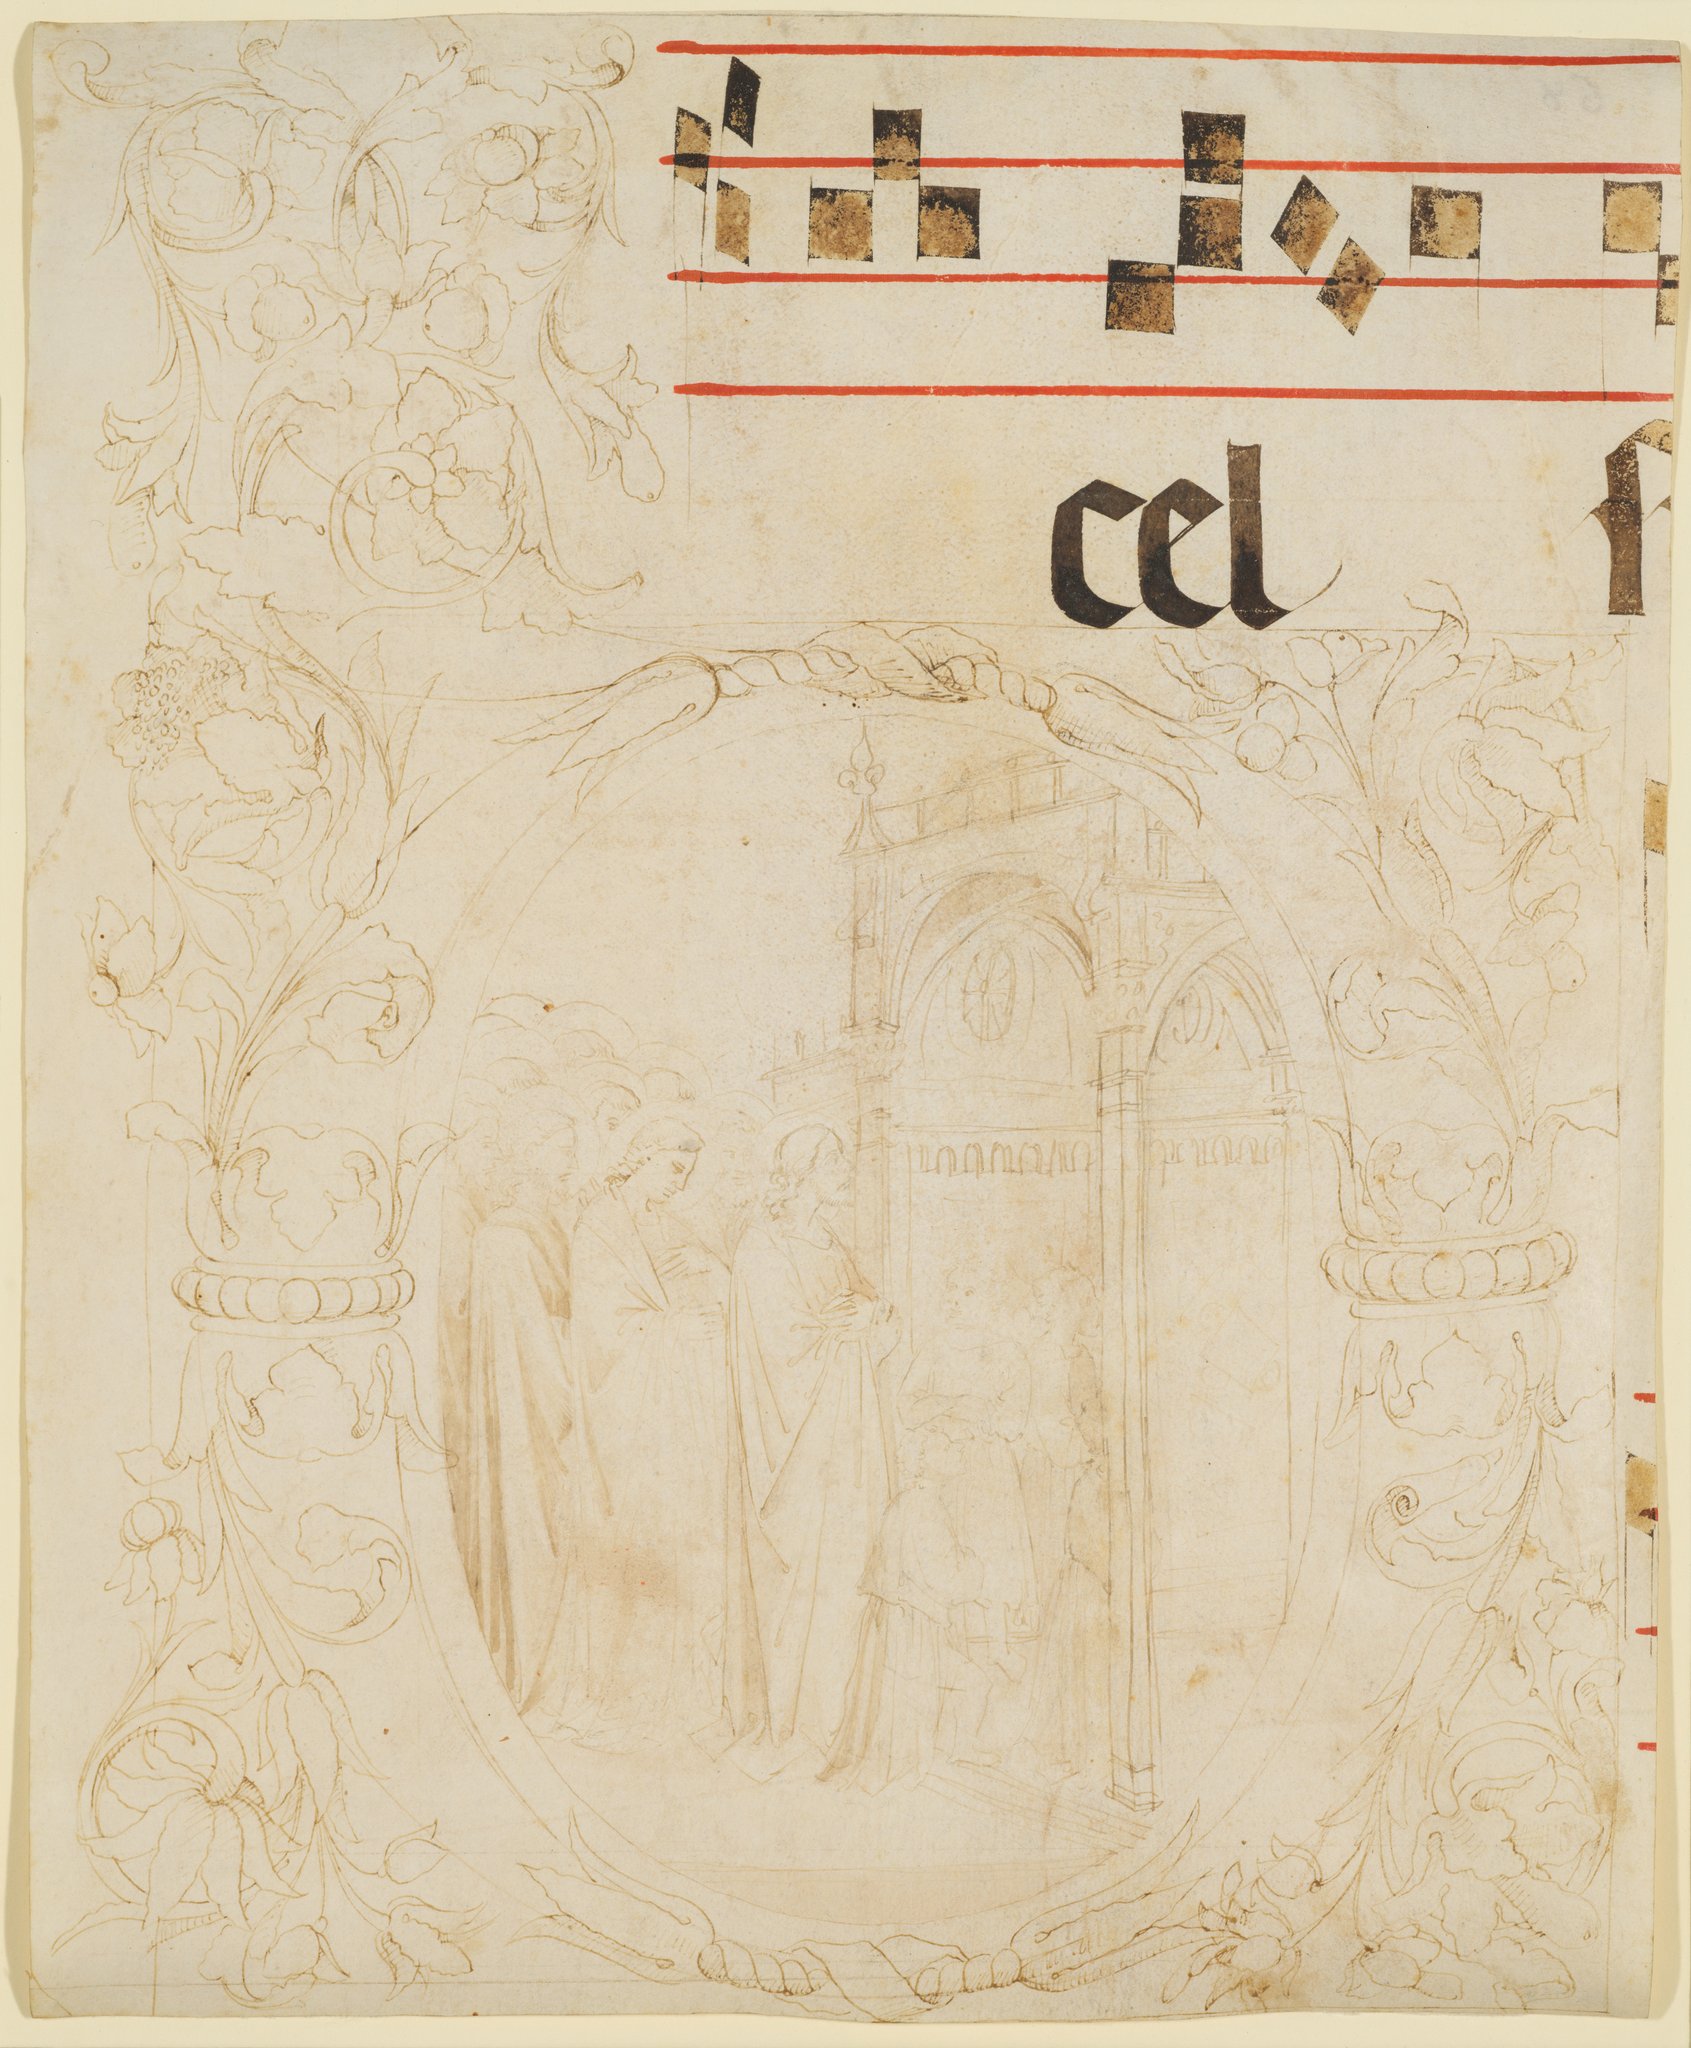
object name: drawing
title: Unfinished Design for a Choir Book: Initial with Scene of Christ Entering the Temple.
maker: lorenzo monaco (piero di giovanni)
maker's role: artist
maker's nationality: italian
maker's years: 1370-1425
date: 1408-1411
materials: ink, drawing material, parchment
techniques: brush, pen, wash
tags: temples,christ